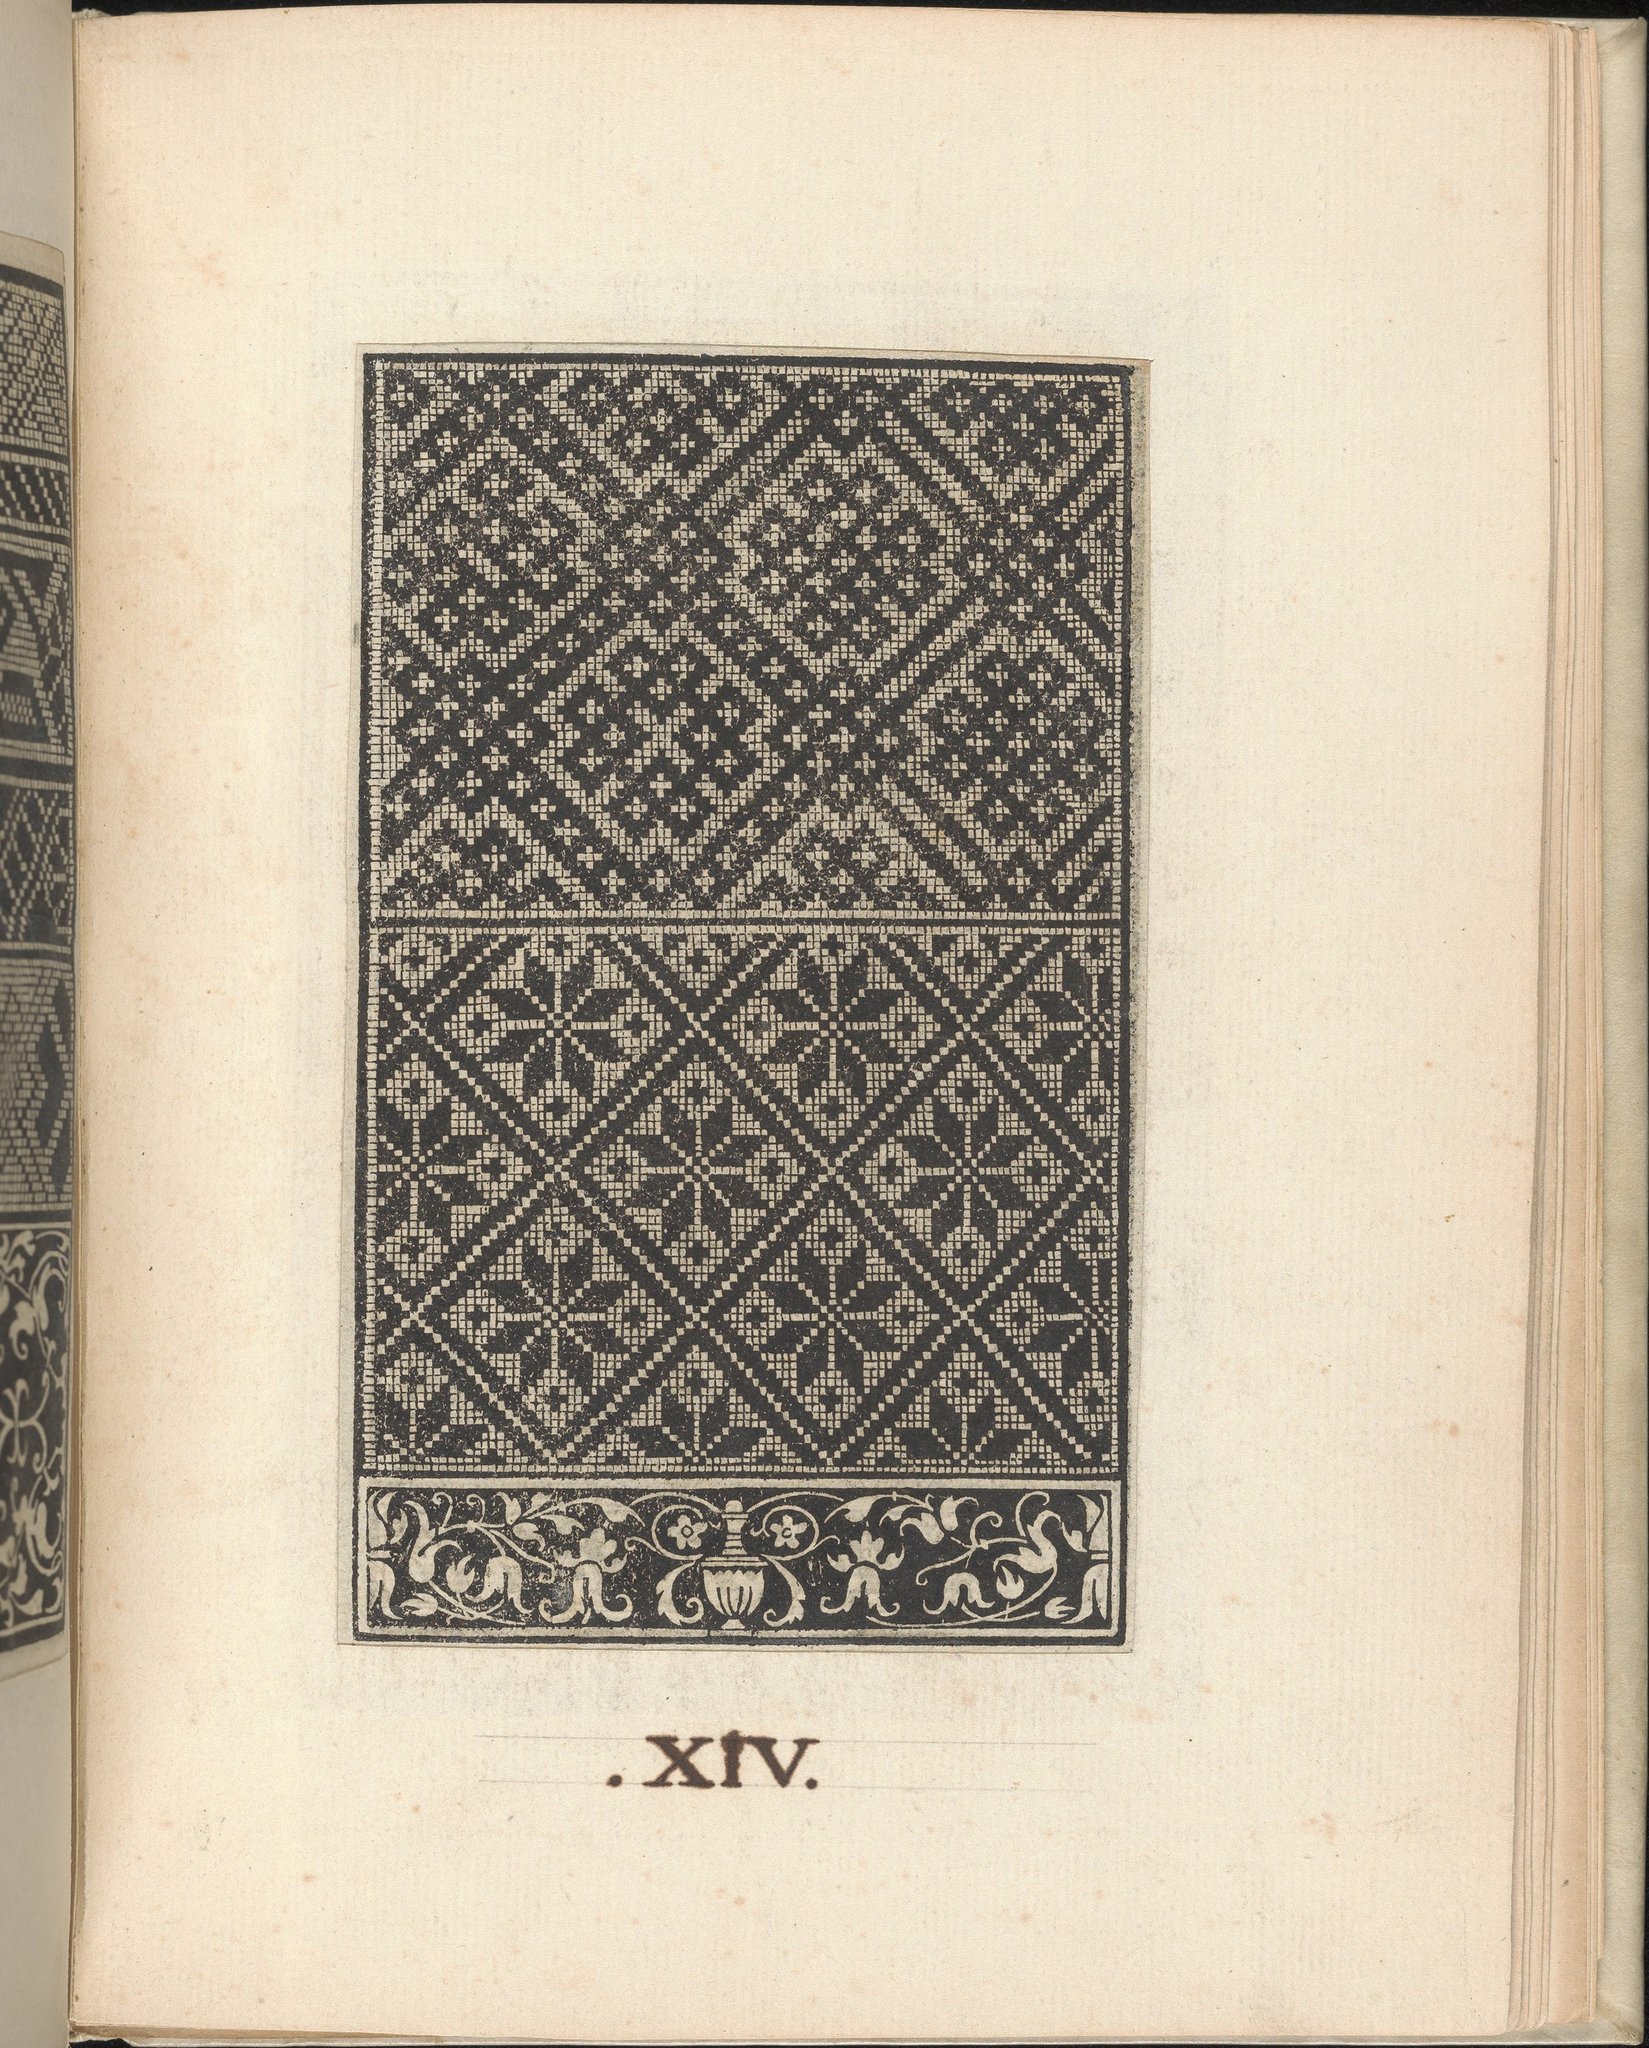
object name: book print ornament architecture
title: Esemplario di lavori, page 14 (recto)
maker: nicolò zoppino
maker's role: publisher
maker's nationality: italian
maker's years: 1478-1544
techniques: bookbinding, inlay, woodcut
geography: italy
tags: ornament